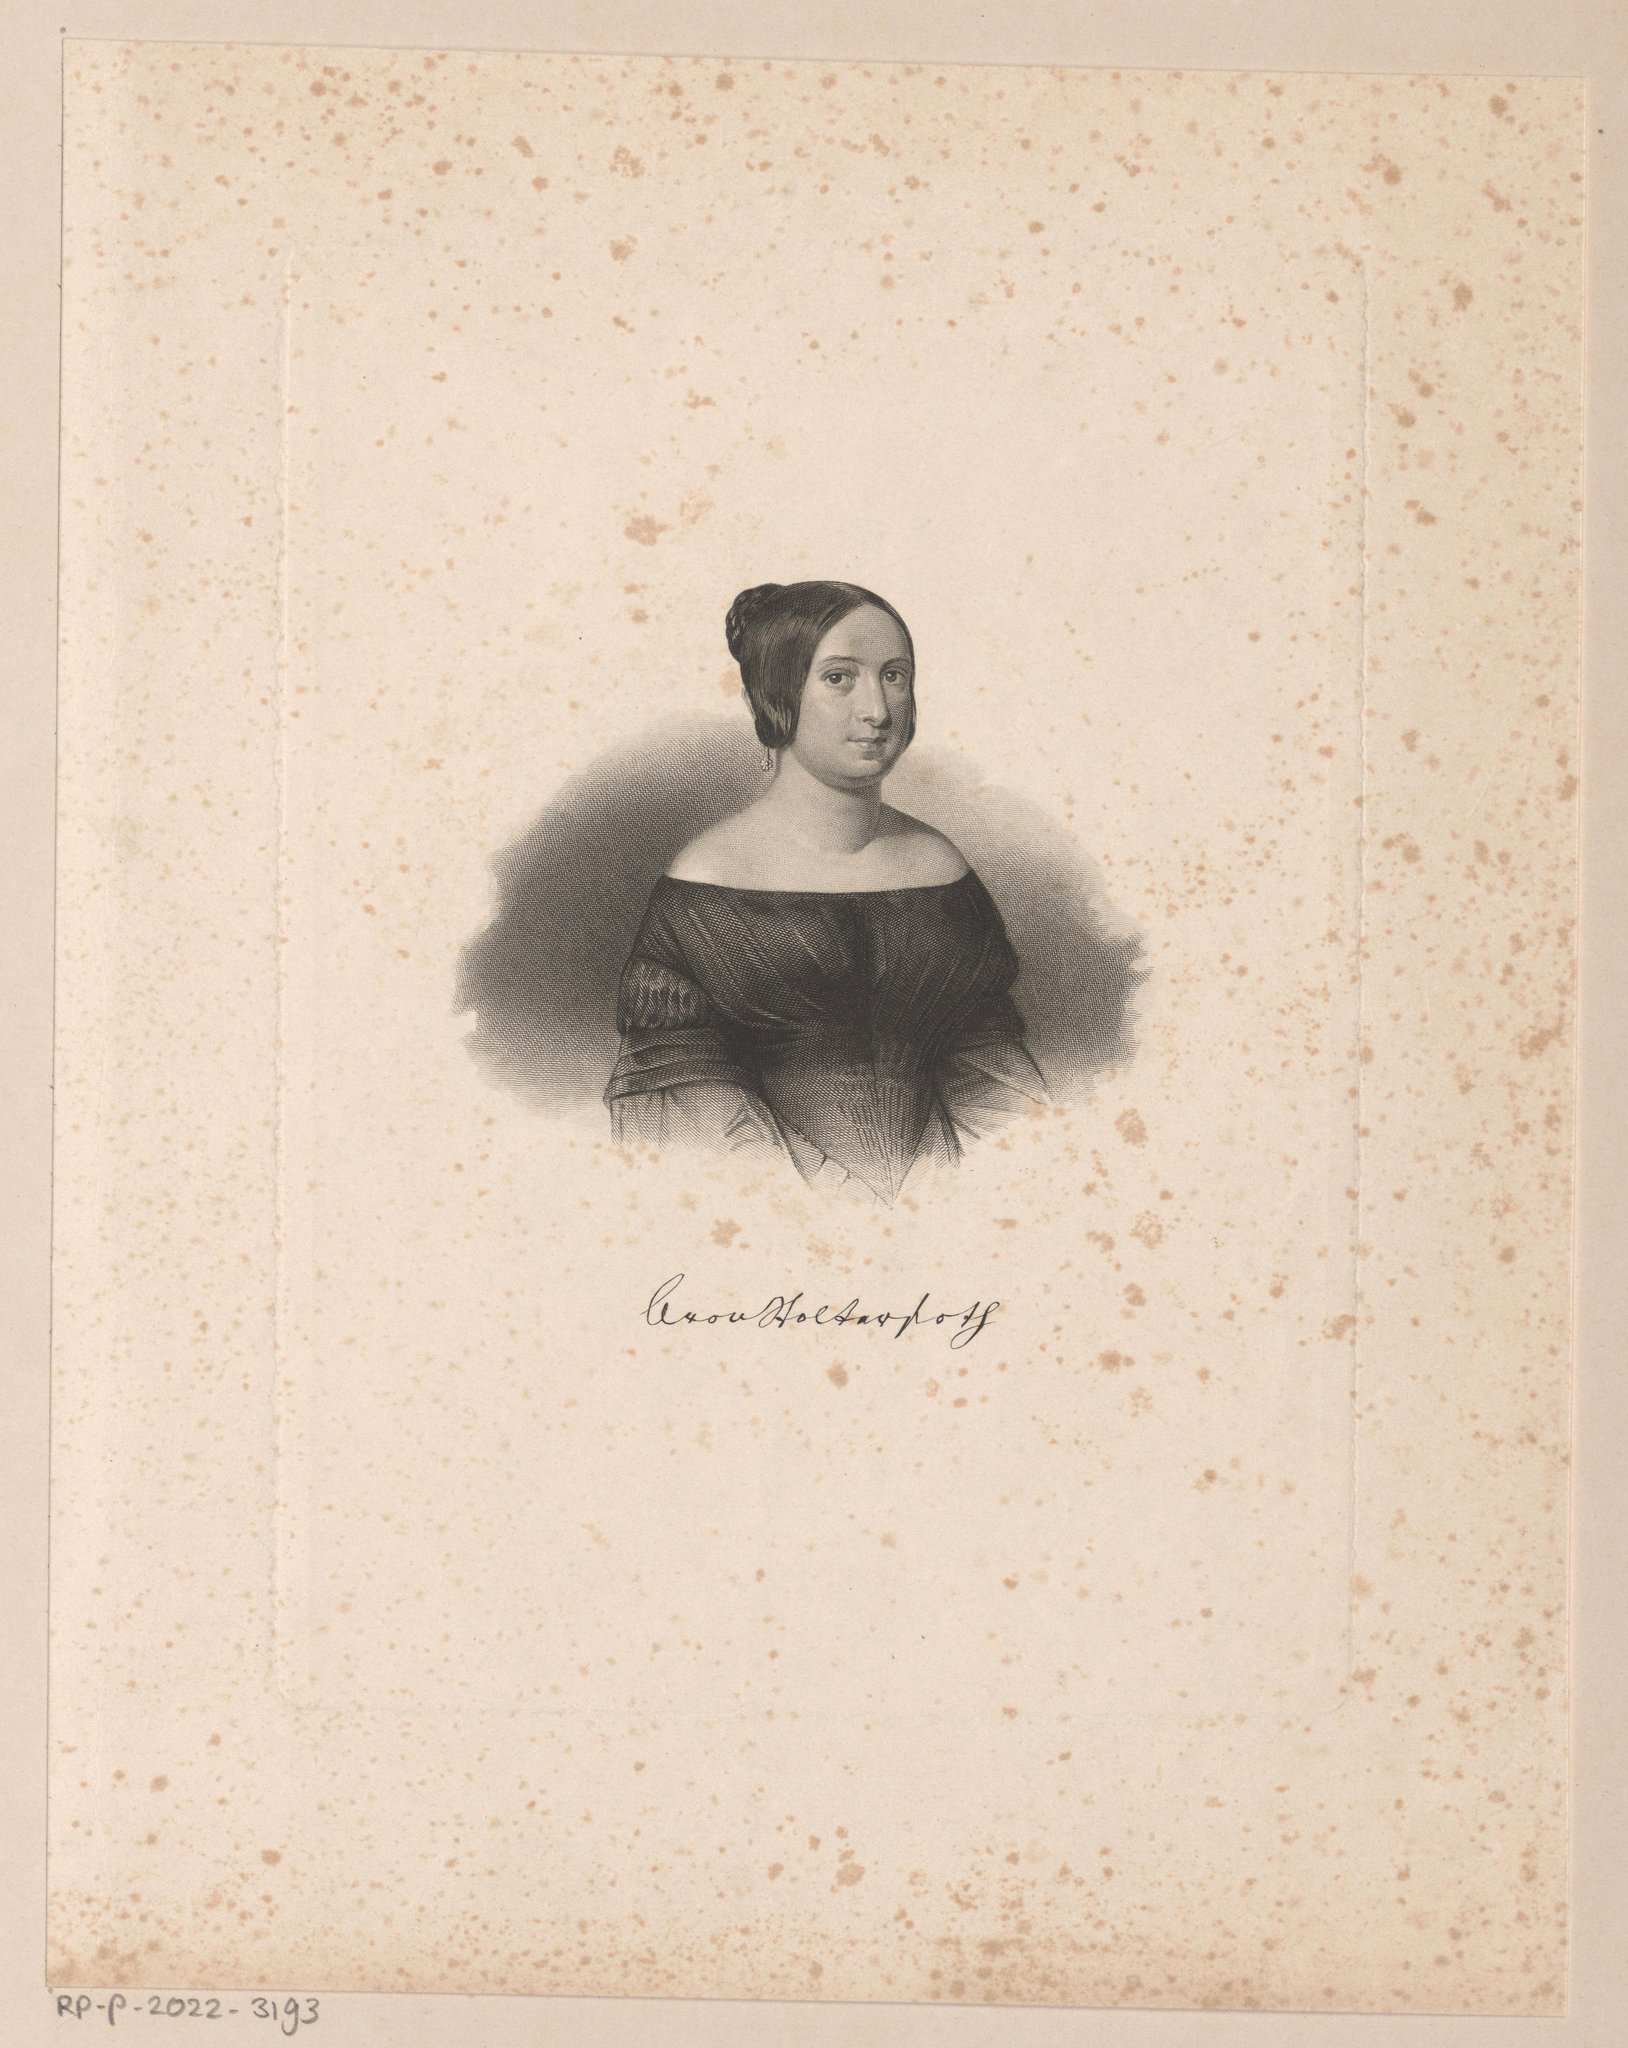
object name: print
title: Portret van een onbekende vrouw met de achternaam Stoltenfotz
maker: Anonymous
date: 1820-1899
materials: paper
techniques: engraving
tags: historical persons not known by name - bb - woman